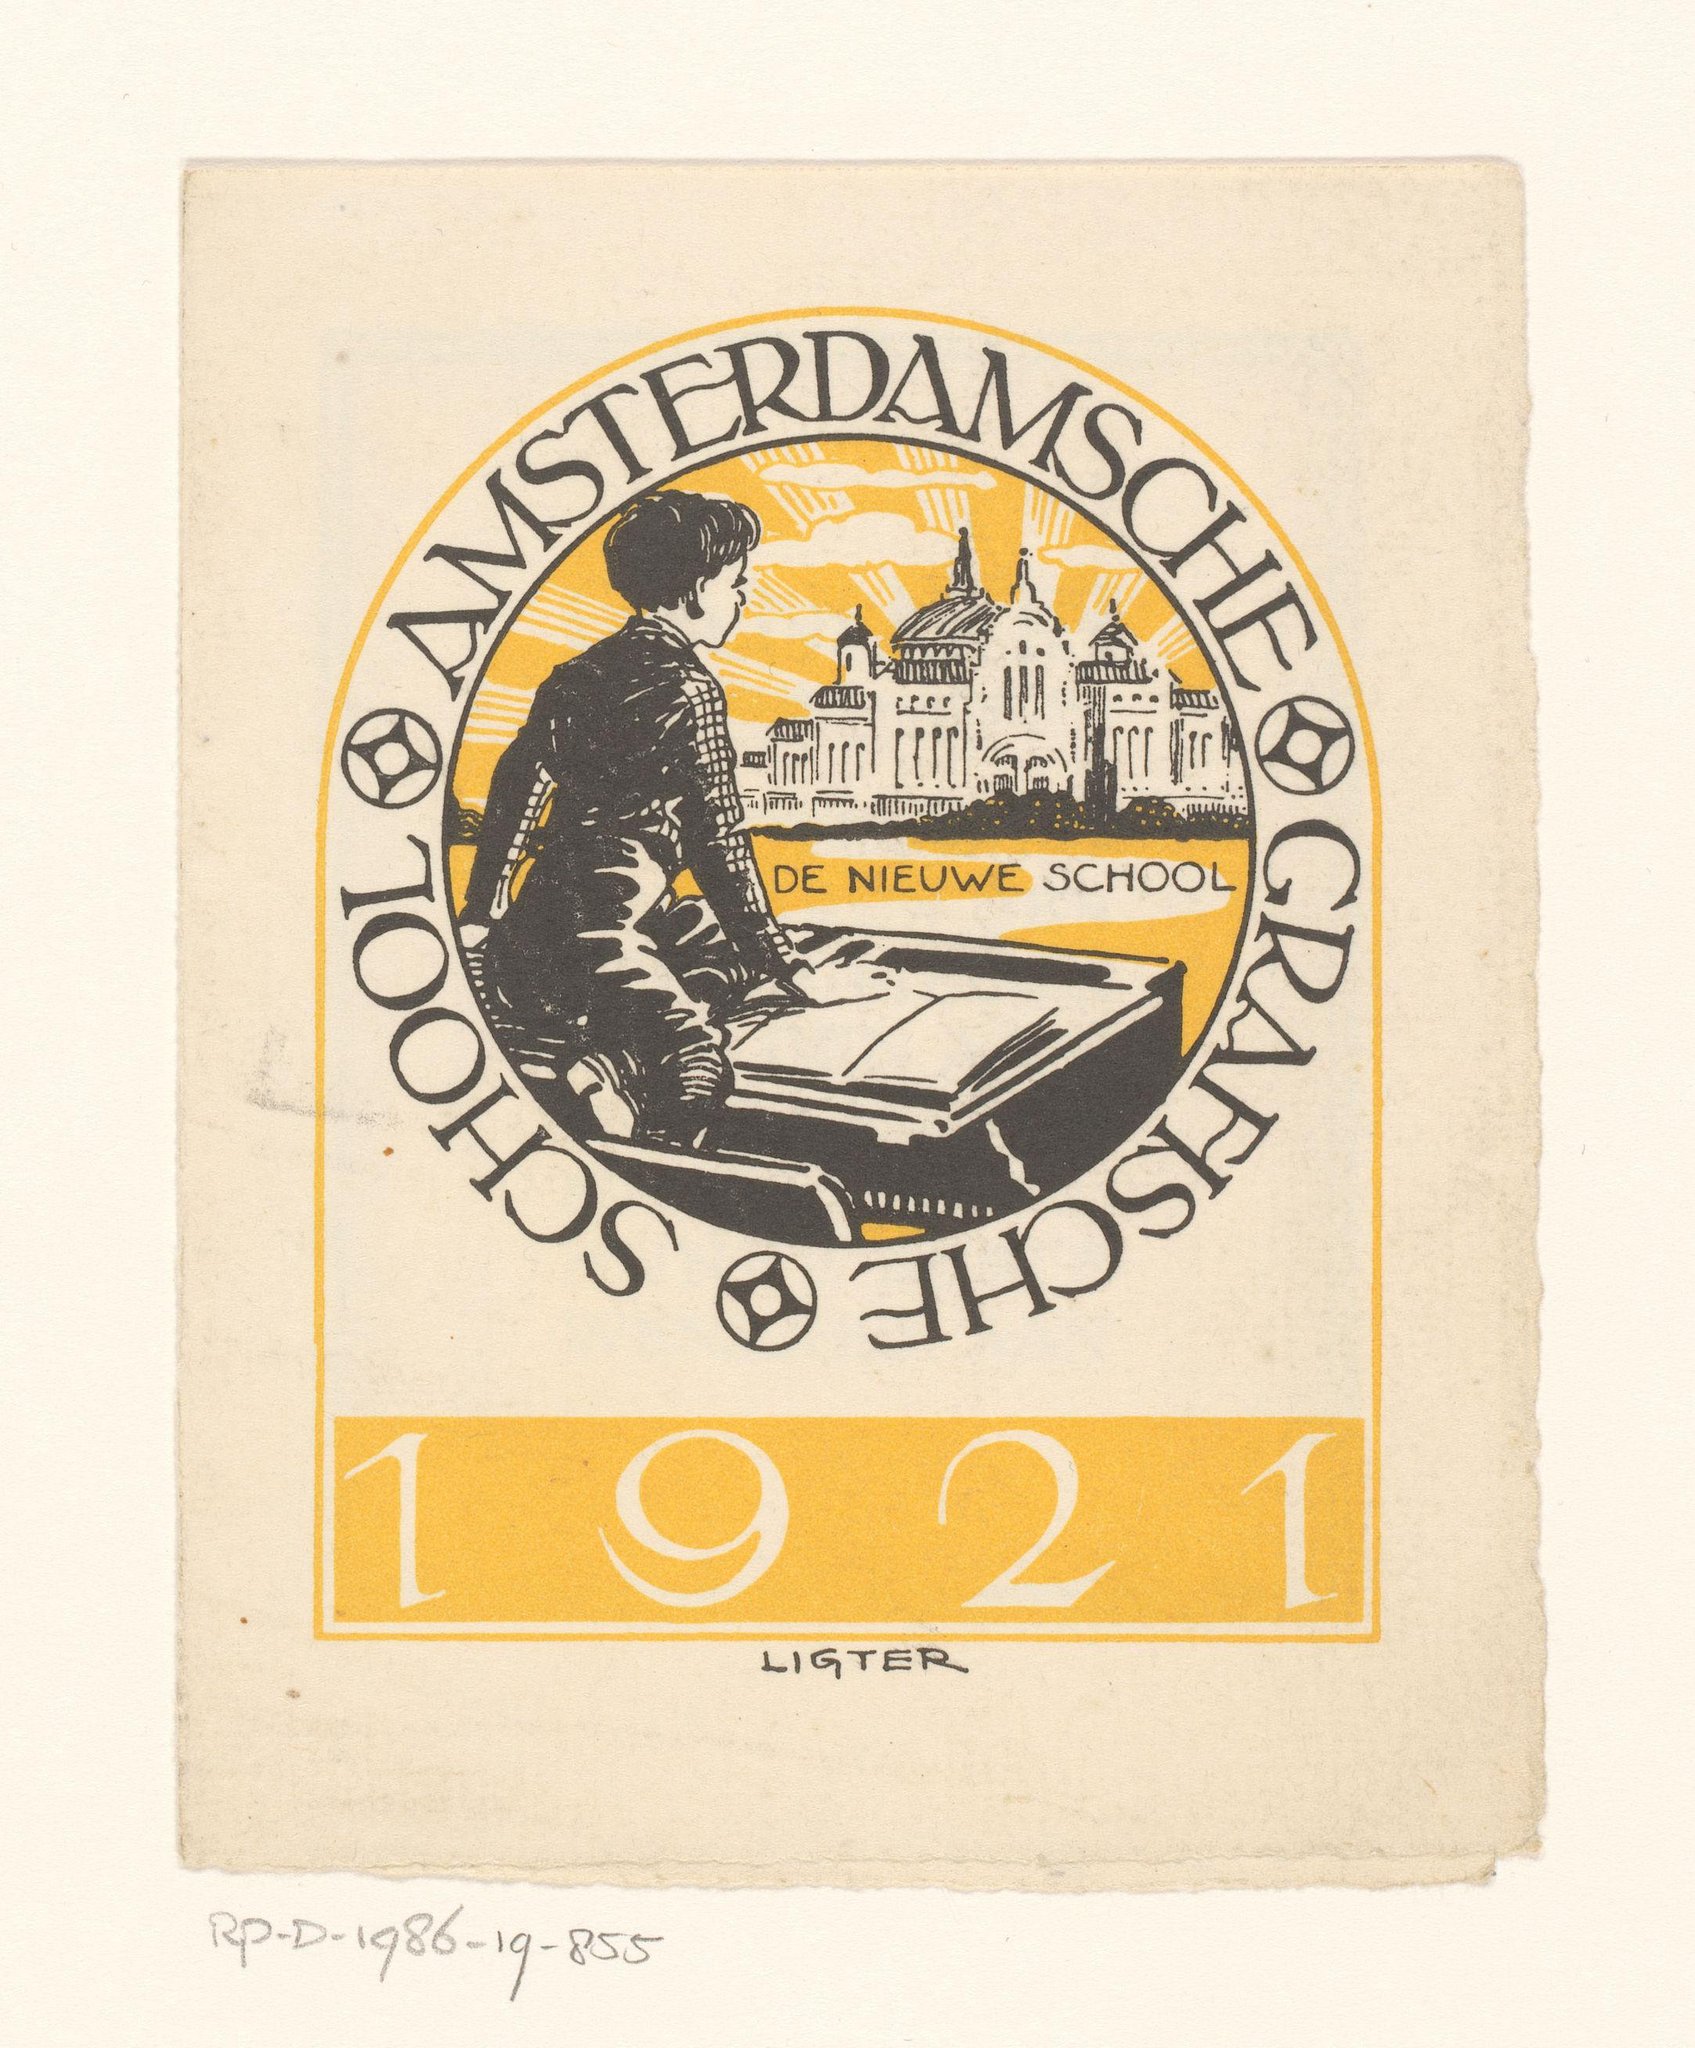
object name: new year card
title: Nieuwjaarswens van de Amsterdamsche Grafische School voor 1921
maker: jan ligter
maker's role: draughtsman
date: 1921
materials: paper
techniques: printing block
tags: civic architecture; edifices; dwellings, lectern ~ reading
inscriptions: date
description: Een jongen zit op een lessenaar en kijkt in de verte naar een gebouw.